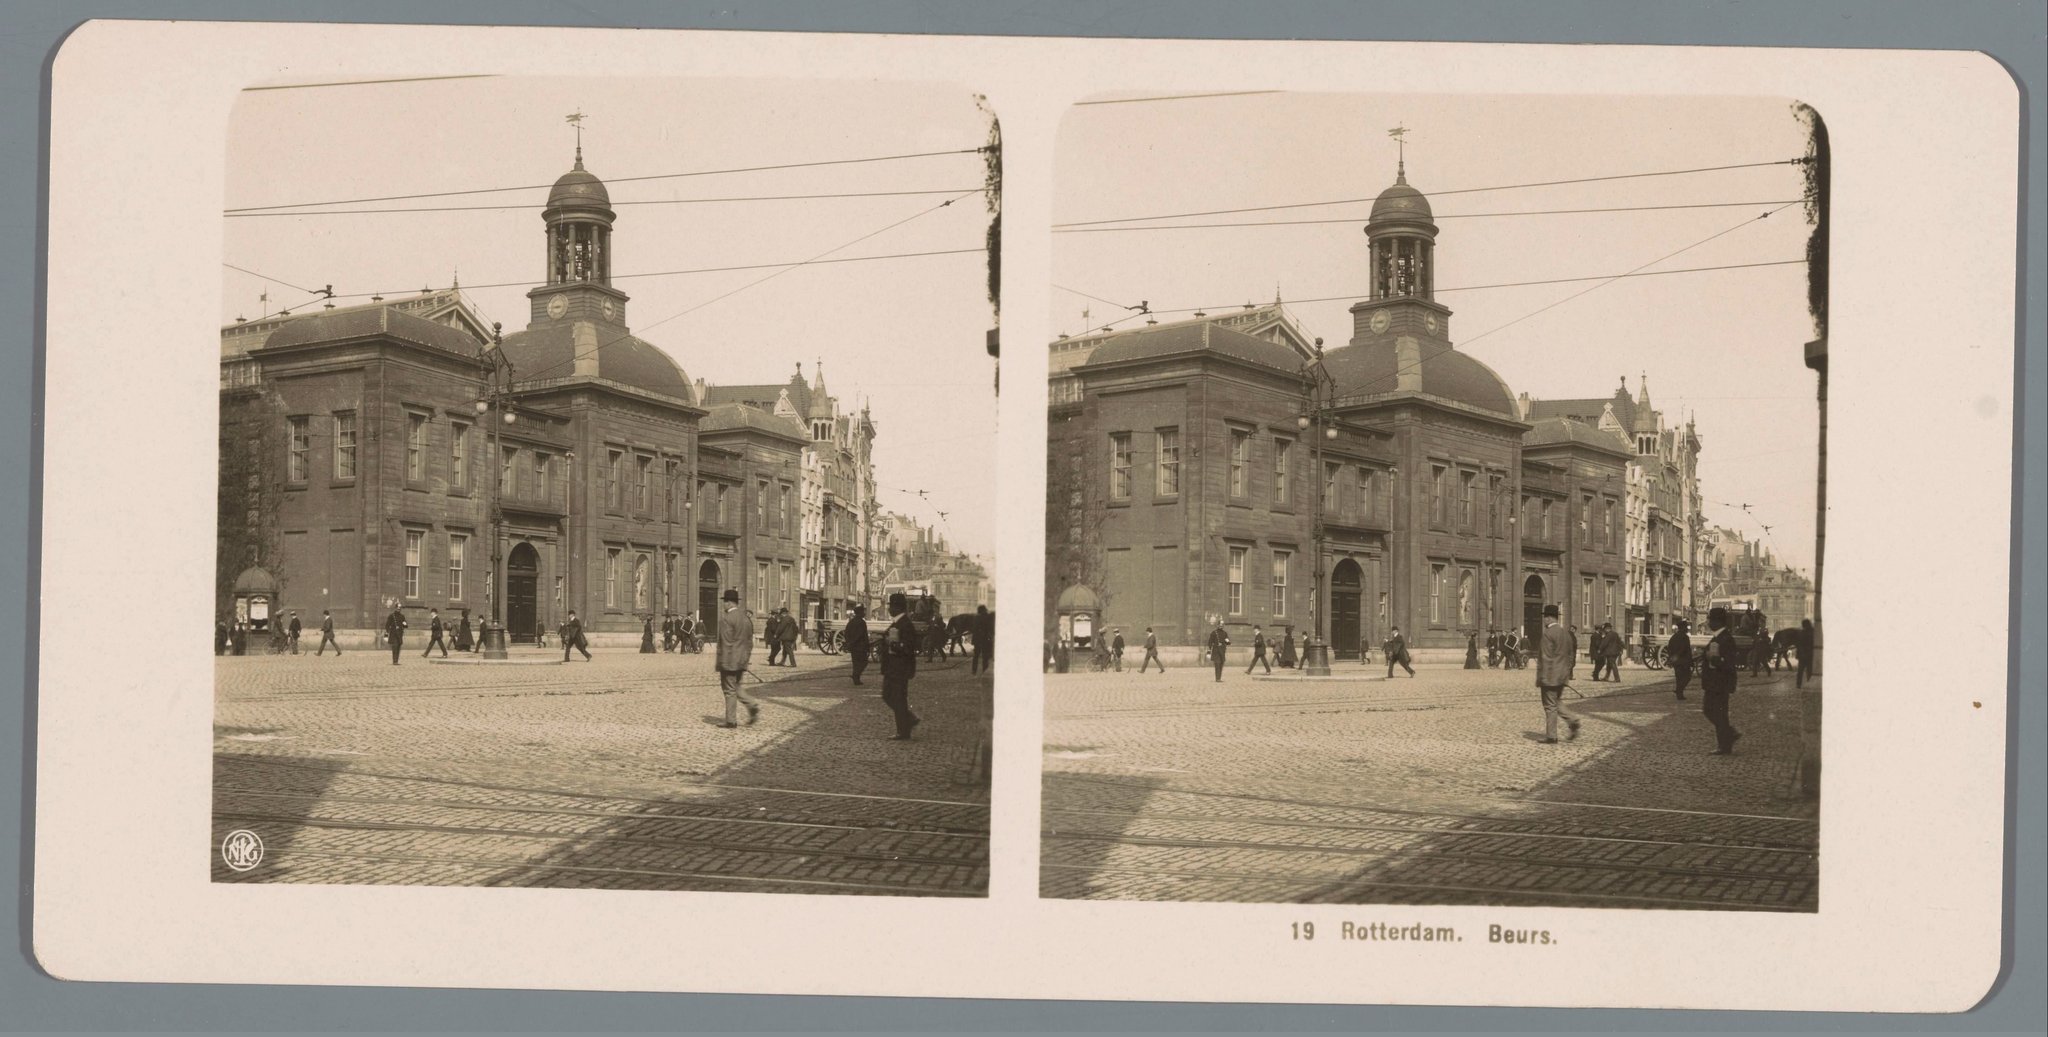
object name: stereograph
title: Gezicht op de beurs van Rotterdam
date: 1900-1910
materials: cardboard, photographic support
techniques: gelatin silver print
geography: rotterdam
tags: stock exchange, stock-market, village square, place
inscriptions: inscription: ‘NPG’, number: ‘19’